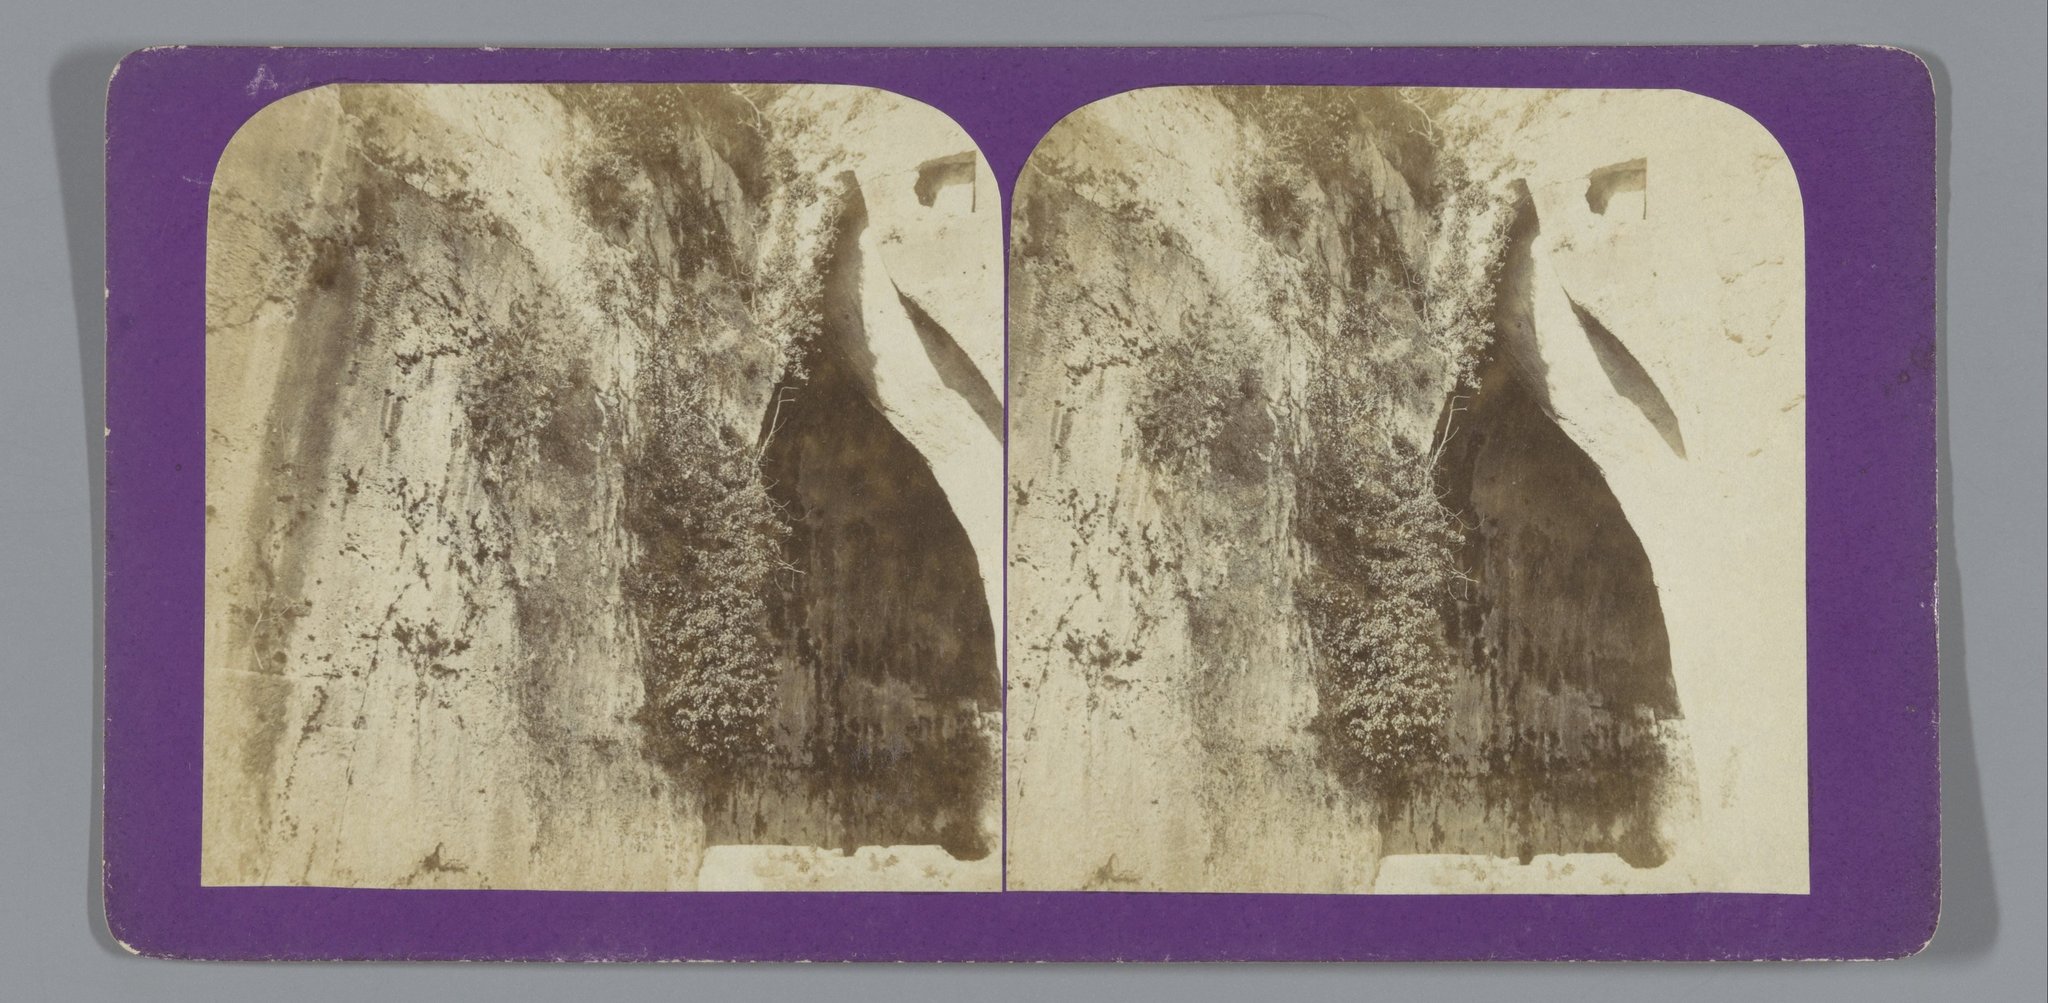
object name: stereograph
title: Gezicht op het Oor van Dionysius, Syracuse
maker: jean andrieu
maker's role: fotograaf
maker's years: 1816-1872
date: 1862-1876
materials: cardboard, paper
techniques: albumen print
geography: syracuse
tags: cave, grotto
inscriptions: title: ‘1326 Oreille de Denys Syracuse’